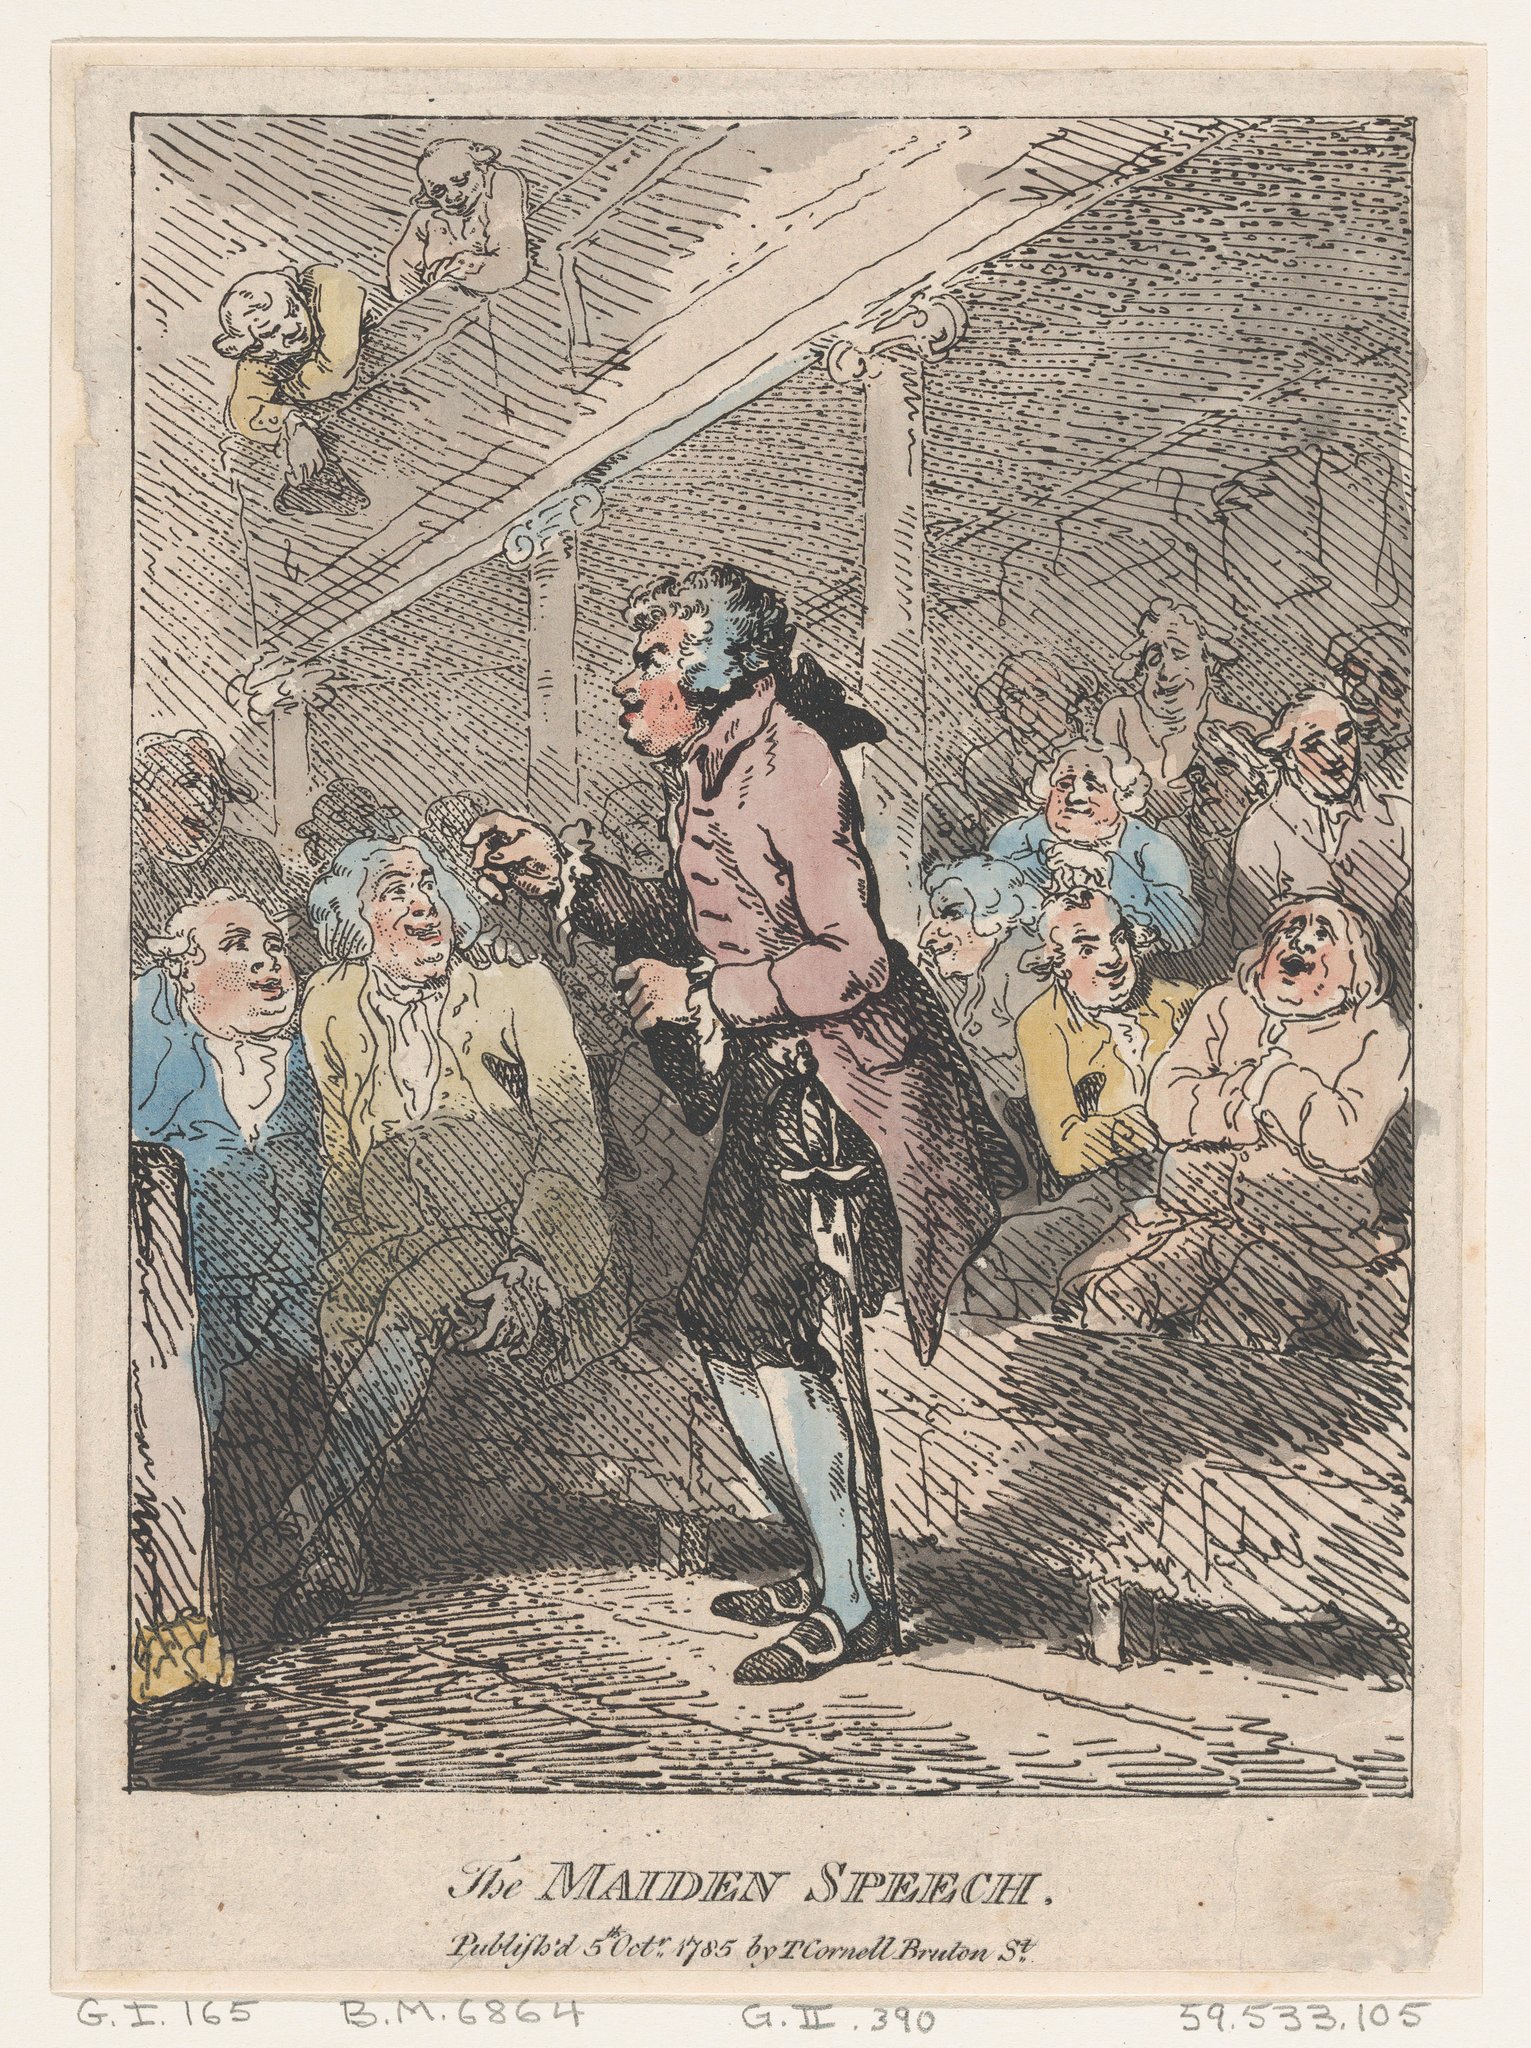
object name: print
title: The Maiden Speech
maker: thomas rowlandson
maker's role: artist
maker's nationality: british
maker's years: 1757-1827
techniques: etching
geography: england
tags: men